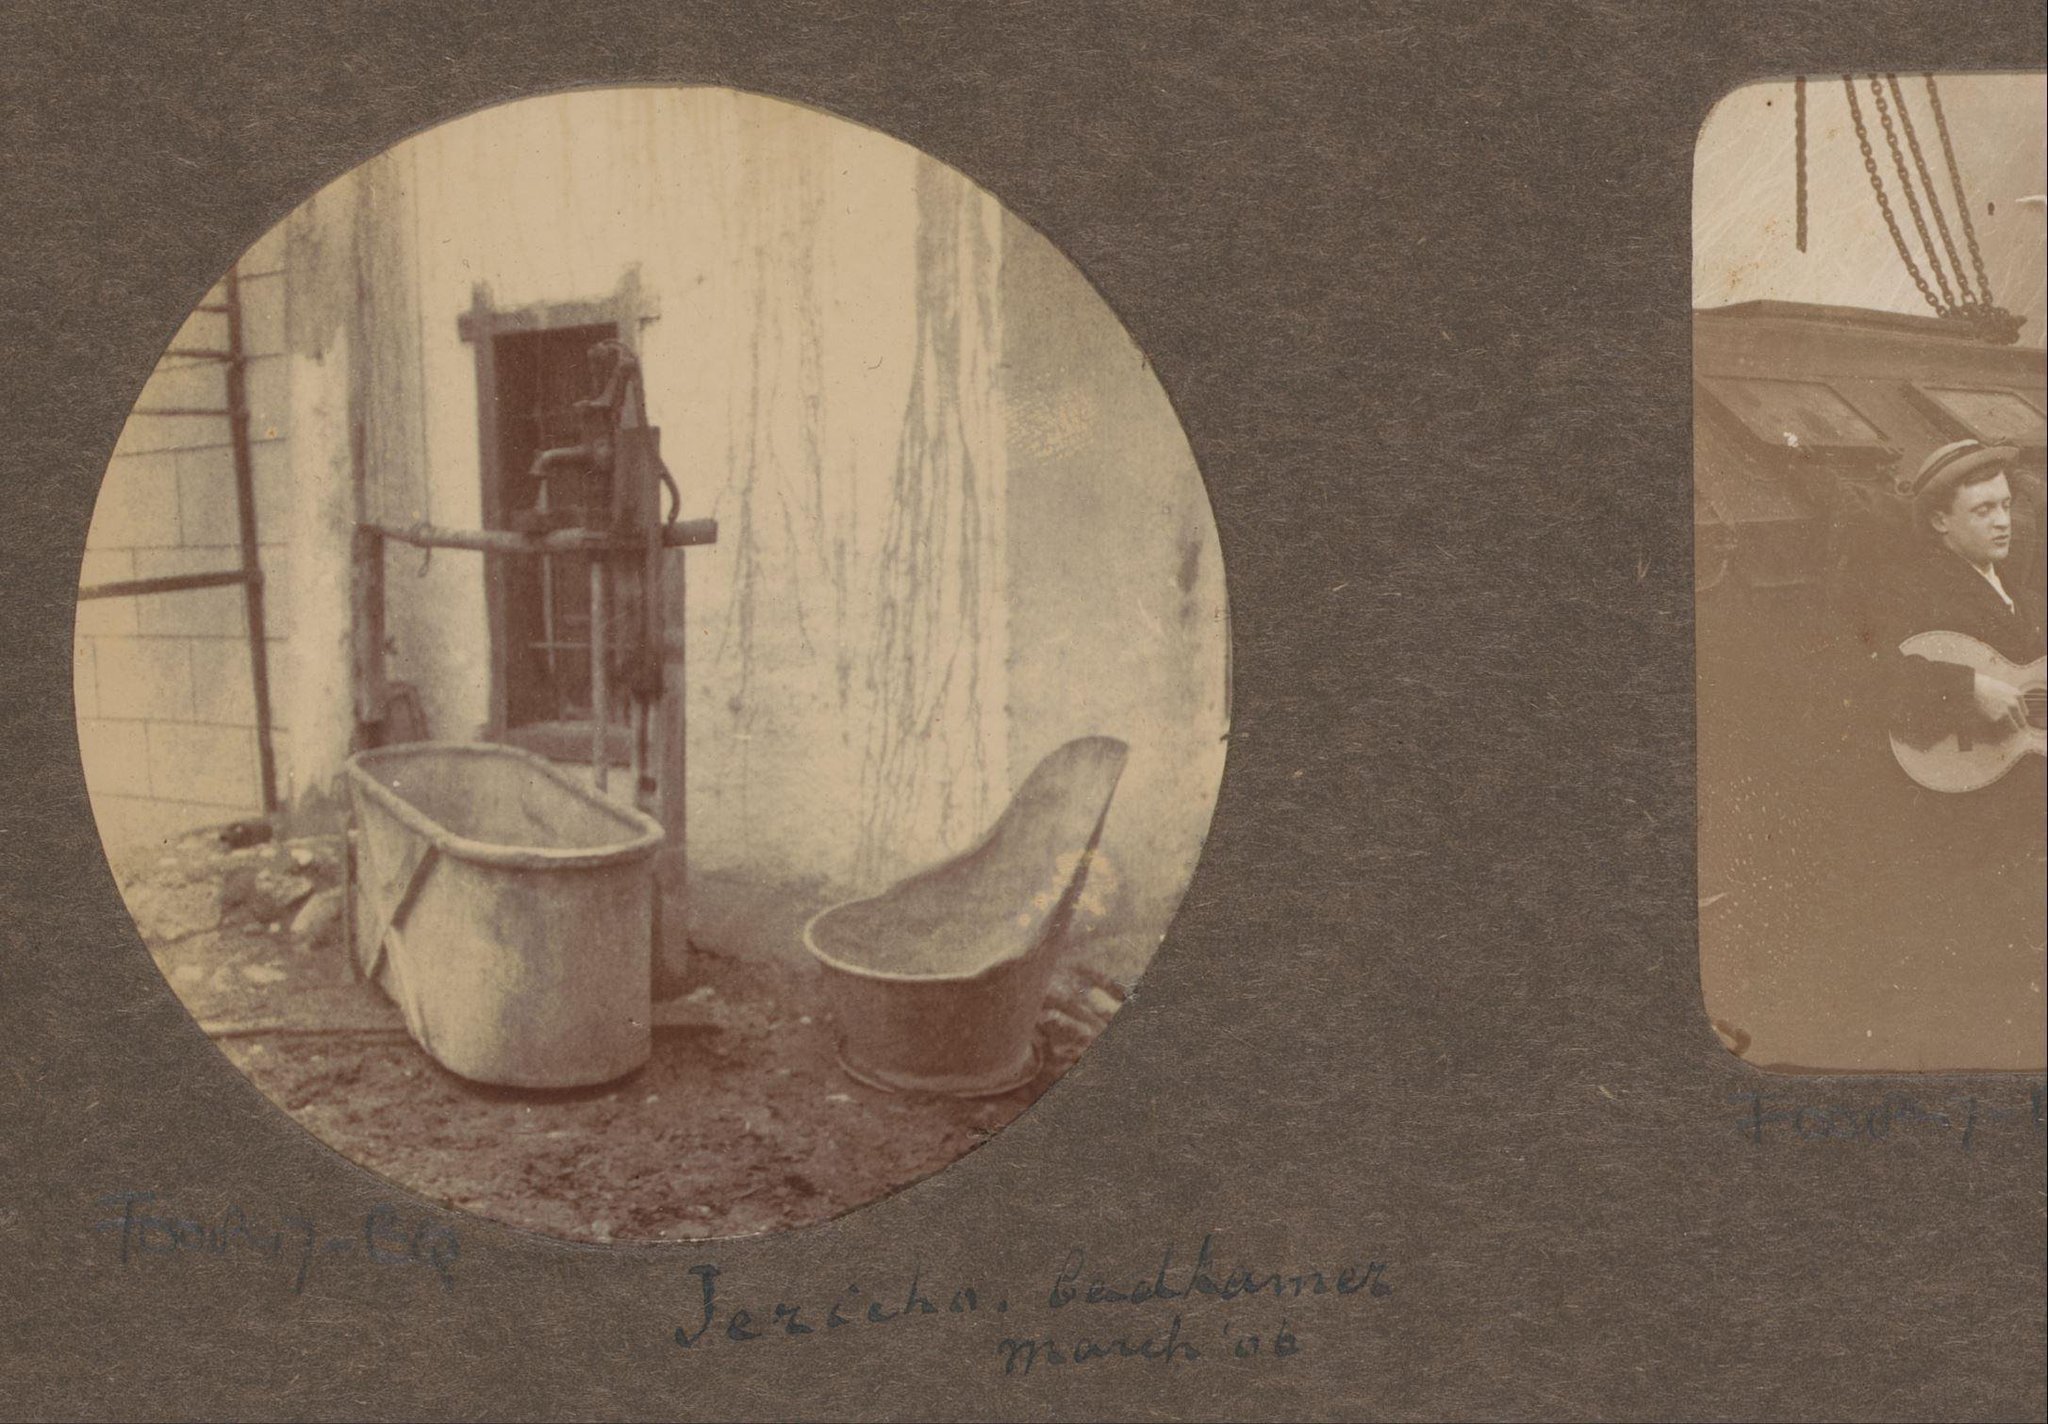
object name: album leaf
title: Badkuipen in de openlucht bij een hotel in Jericho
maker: Anonymous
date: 1903-1906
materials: cardboard, paper, photographic support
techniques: gelatin silver print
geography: jericho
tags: bathroom, bath-tub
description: Onderdeel van Reisalbum van een Nederlandse familie met bezienswaardigheden in Europa, Egypte en New York.